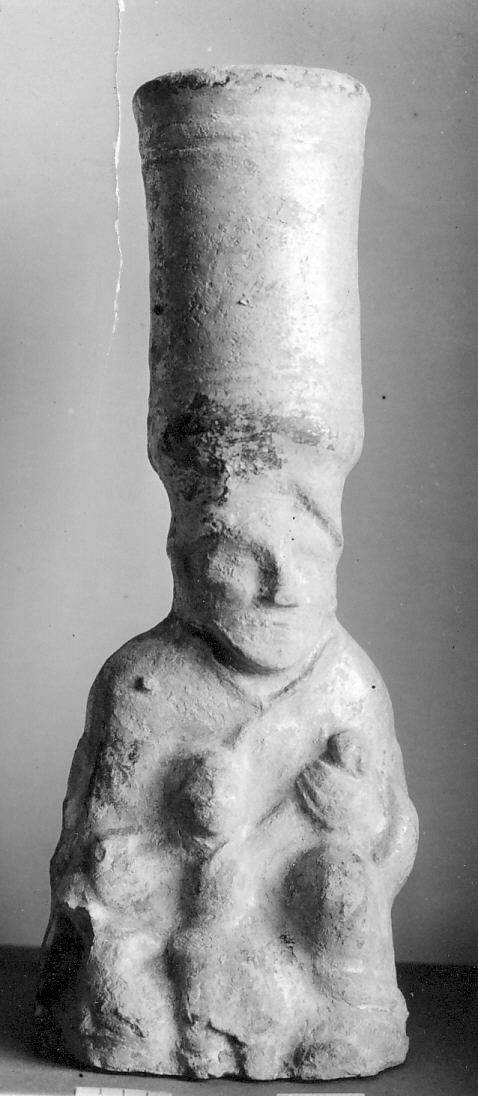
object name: figure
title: Figure of a Man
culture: chinese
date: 206 BCE-220 CE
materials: pottery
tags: men